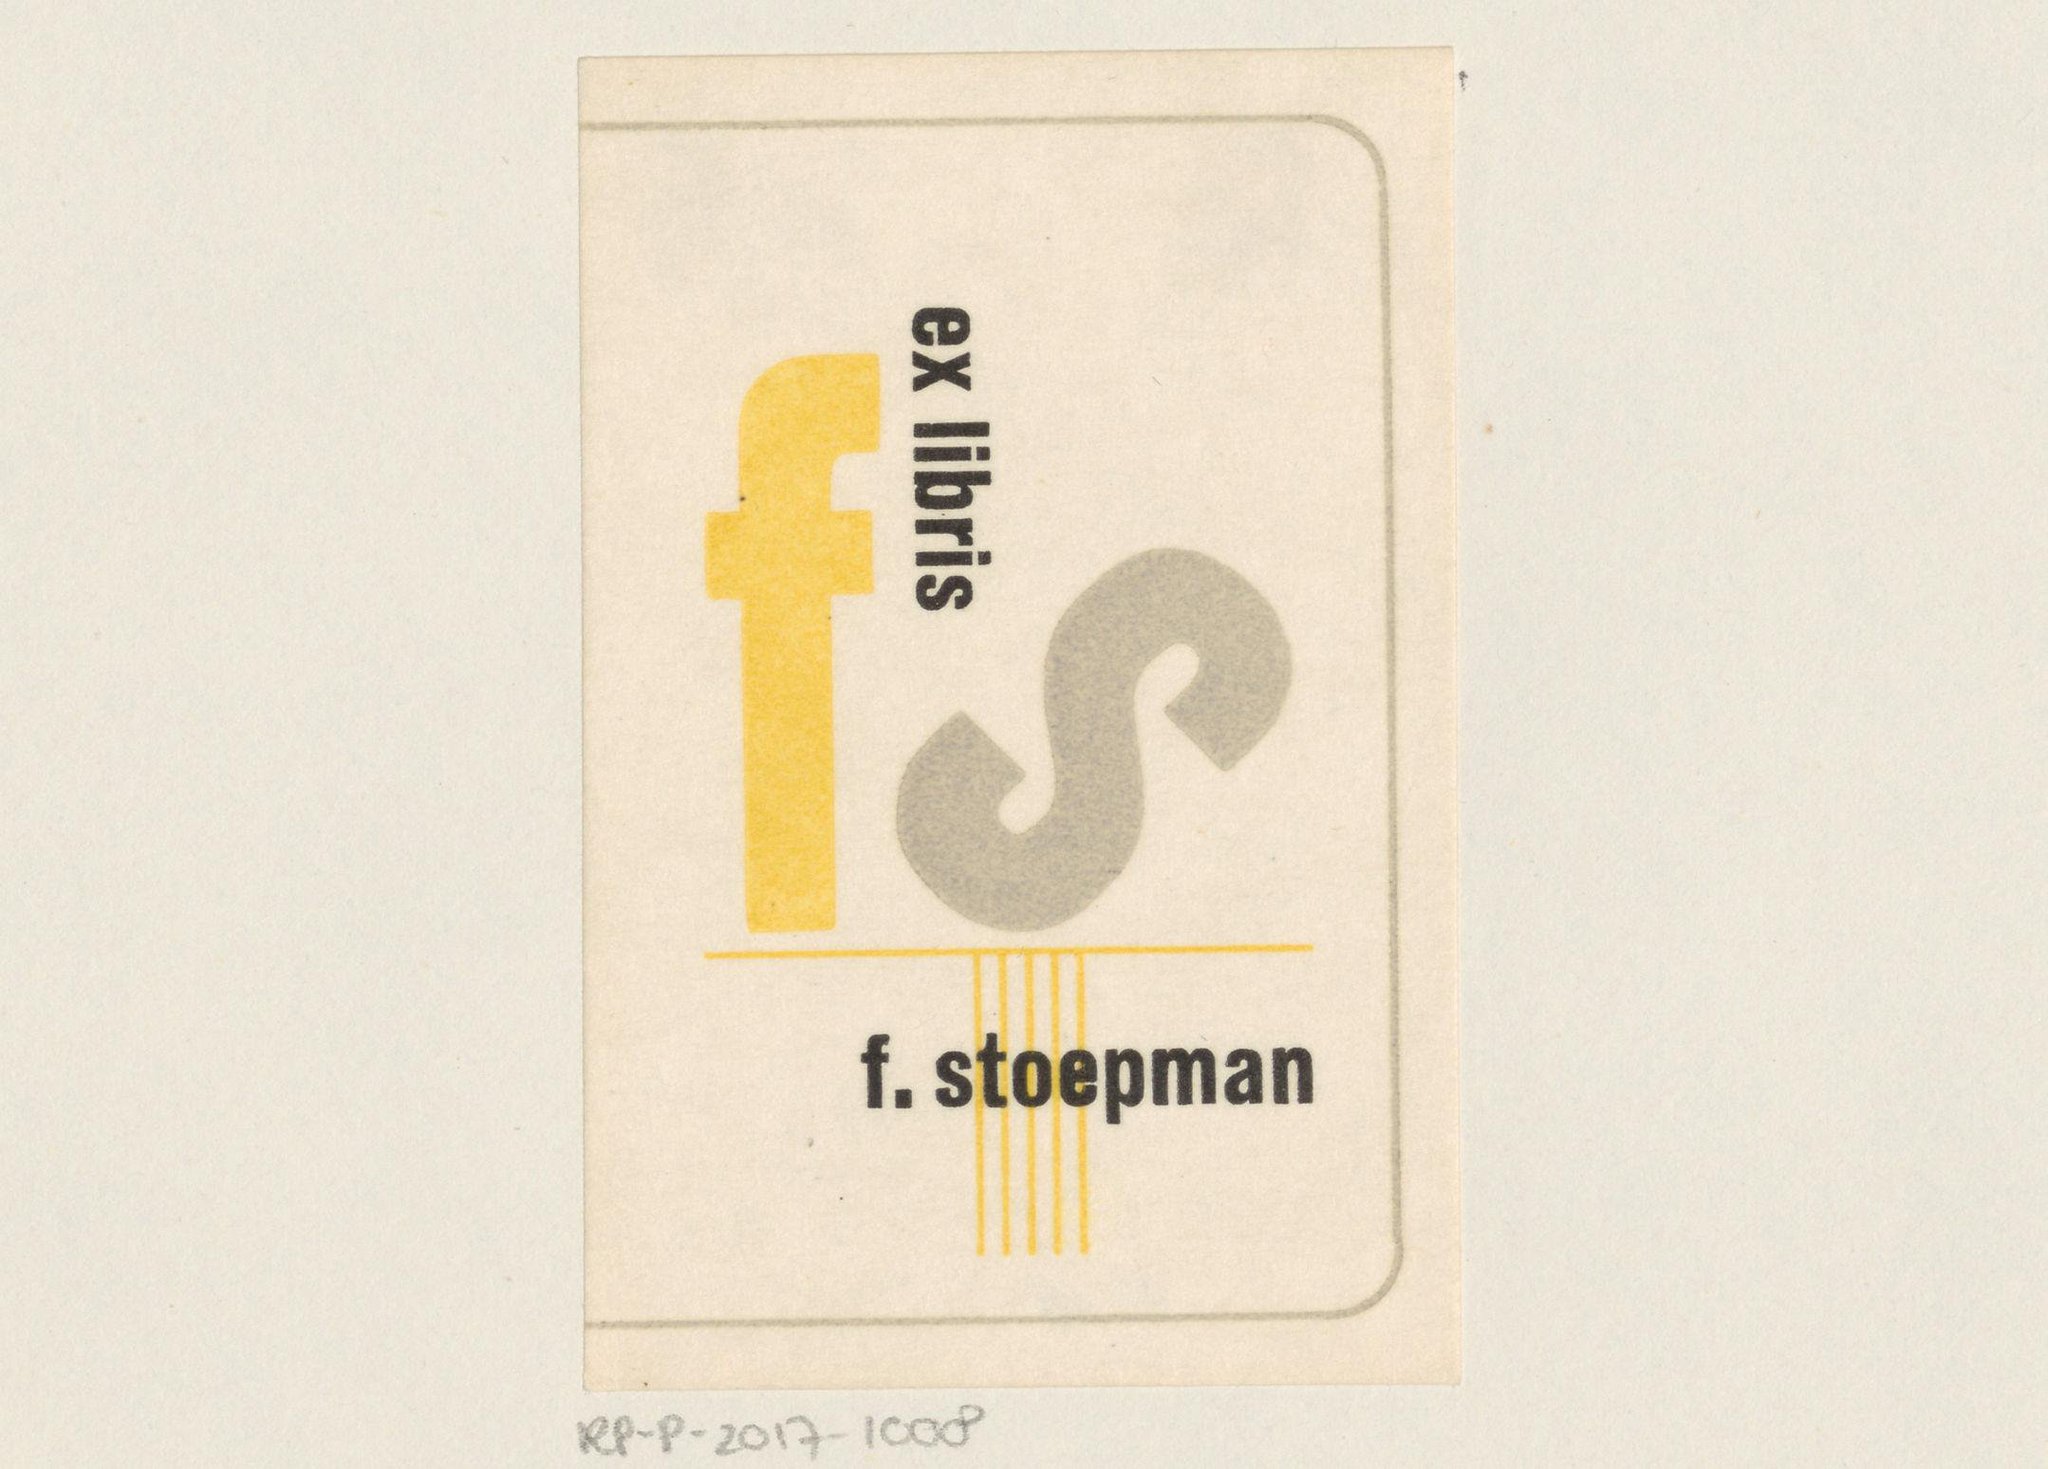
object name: bookplate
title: Ex libris van F. Stoepman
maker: Anonymous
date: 1900-1999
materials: paper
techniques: printing block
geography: netherlands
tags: f. stoepman